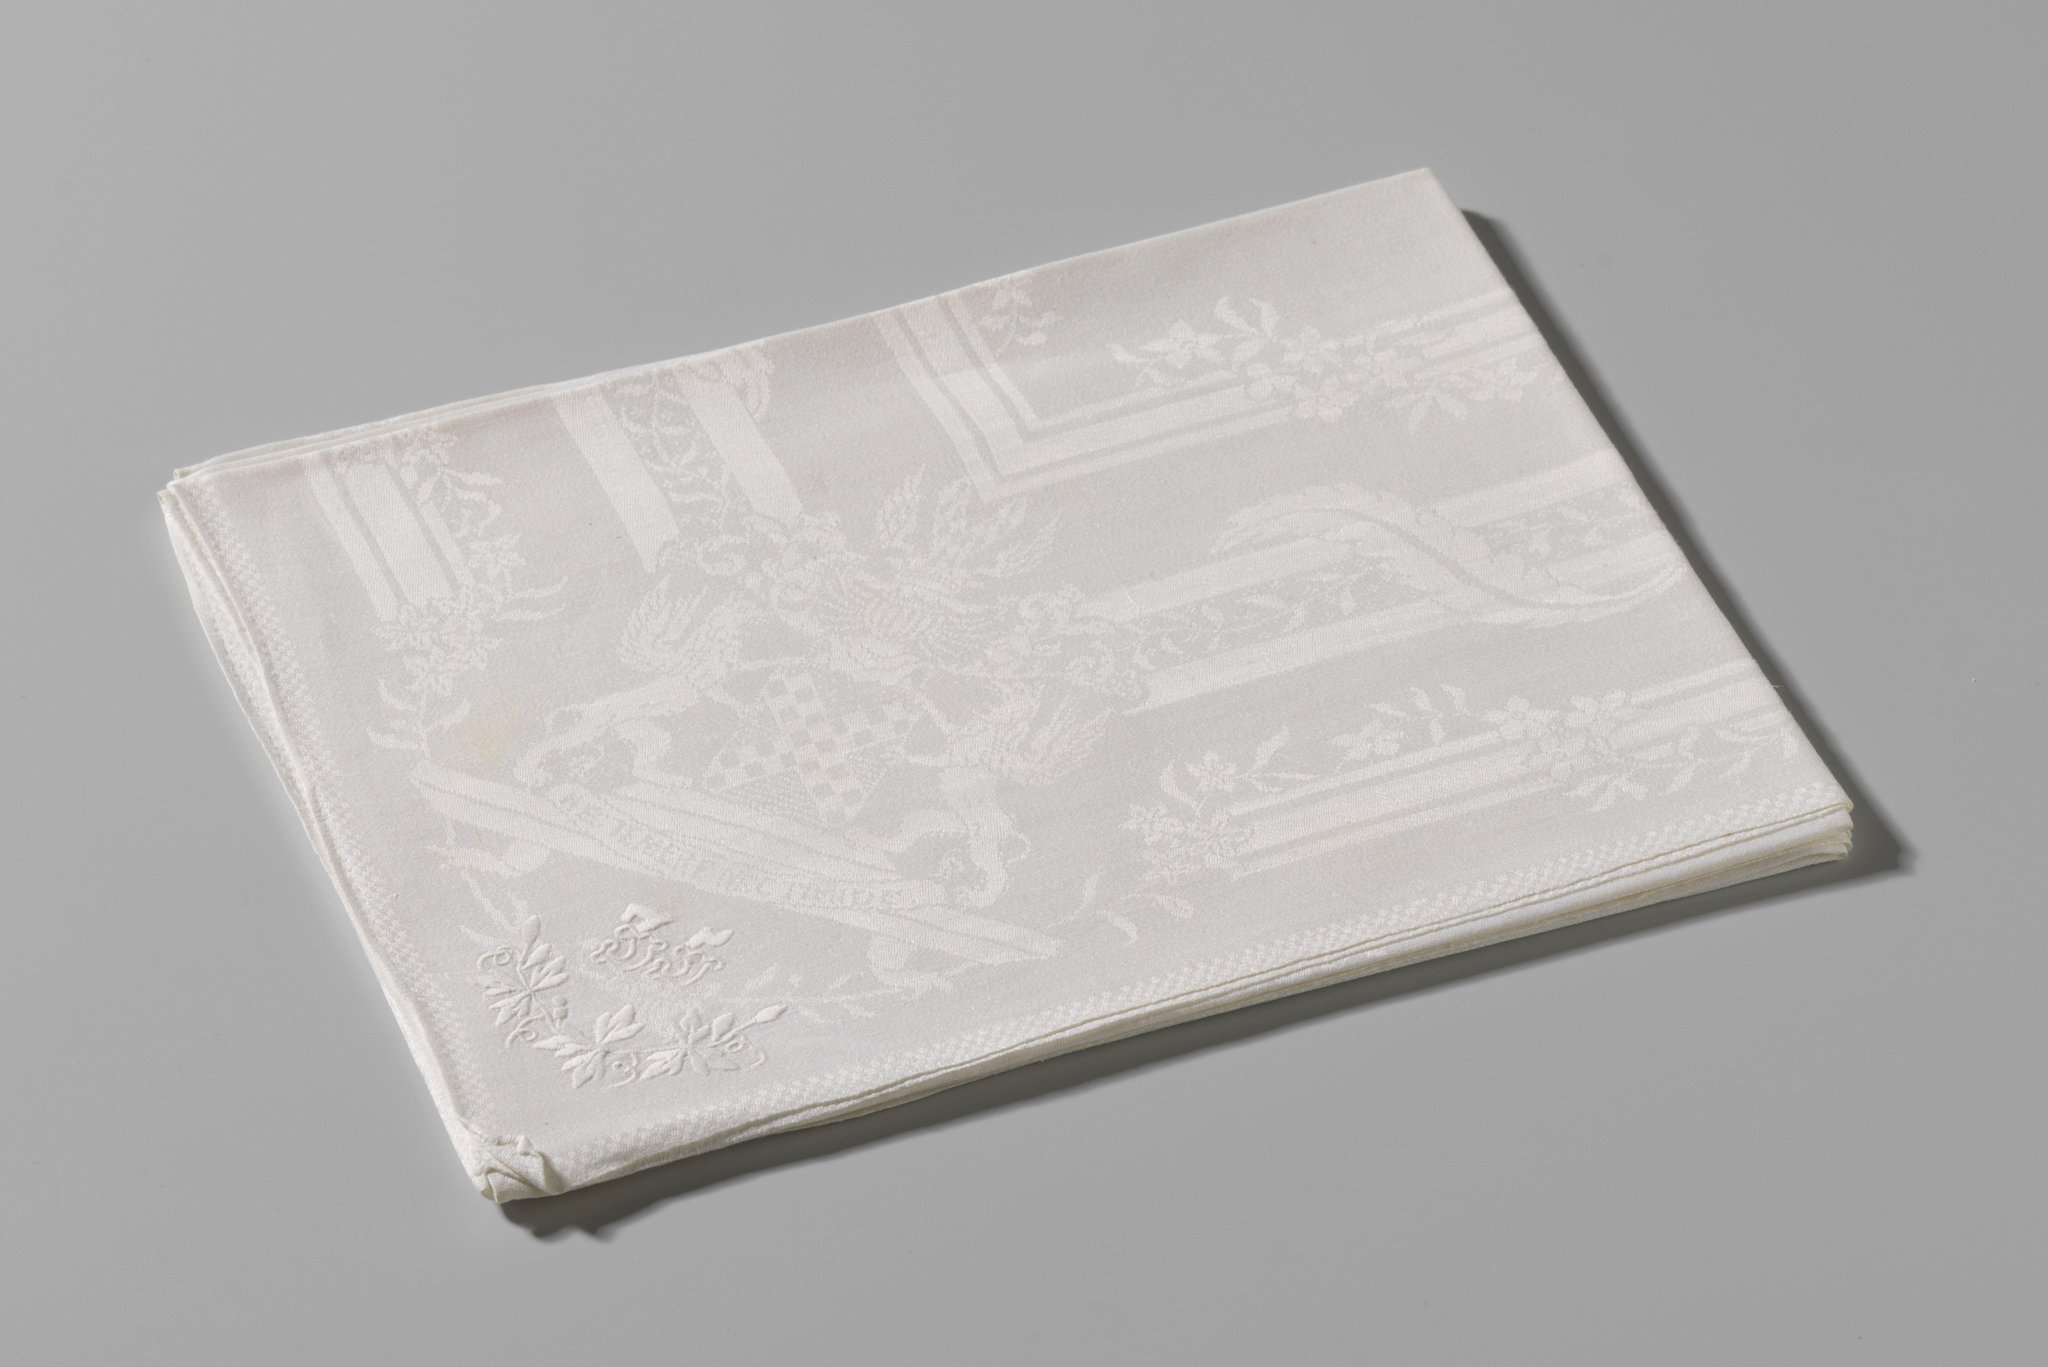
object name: napkin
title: Servet met het familiewapen Van der Dussen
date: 1870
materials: linen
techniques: damask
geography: boxtel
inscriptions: mark: ‘bladrank 35’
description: Servet van linnendamast met het familiewapen Van der Dussen. Middenveld: wapenschild temidden van gestrooide bloemknoppen. Randen: drie drievoudige banden, de middelste met een bladrank, de andere glad en omslingerd met een spiraaltak.